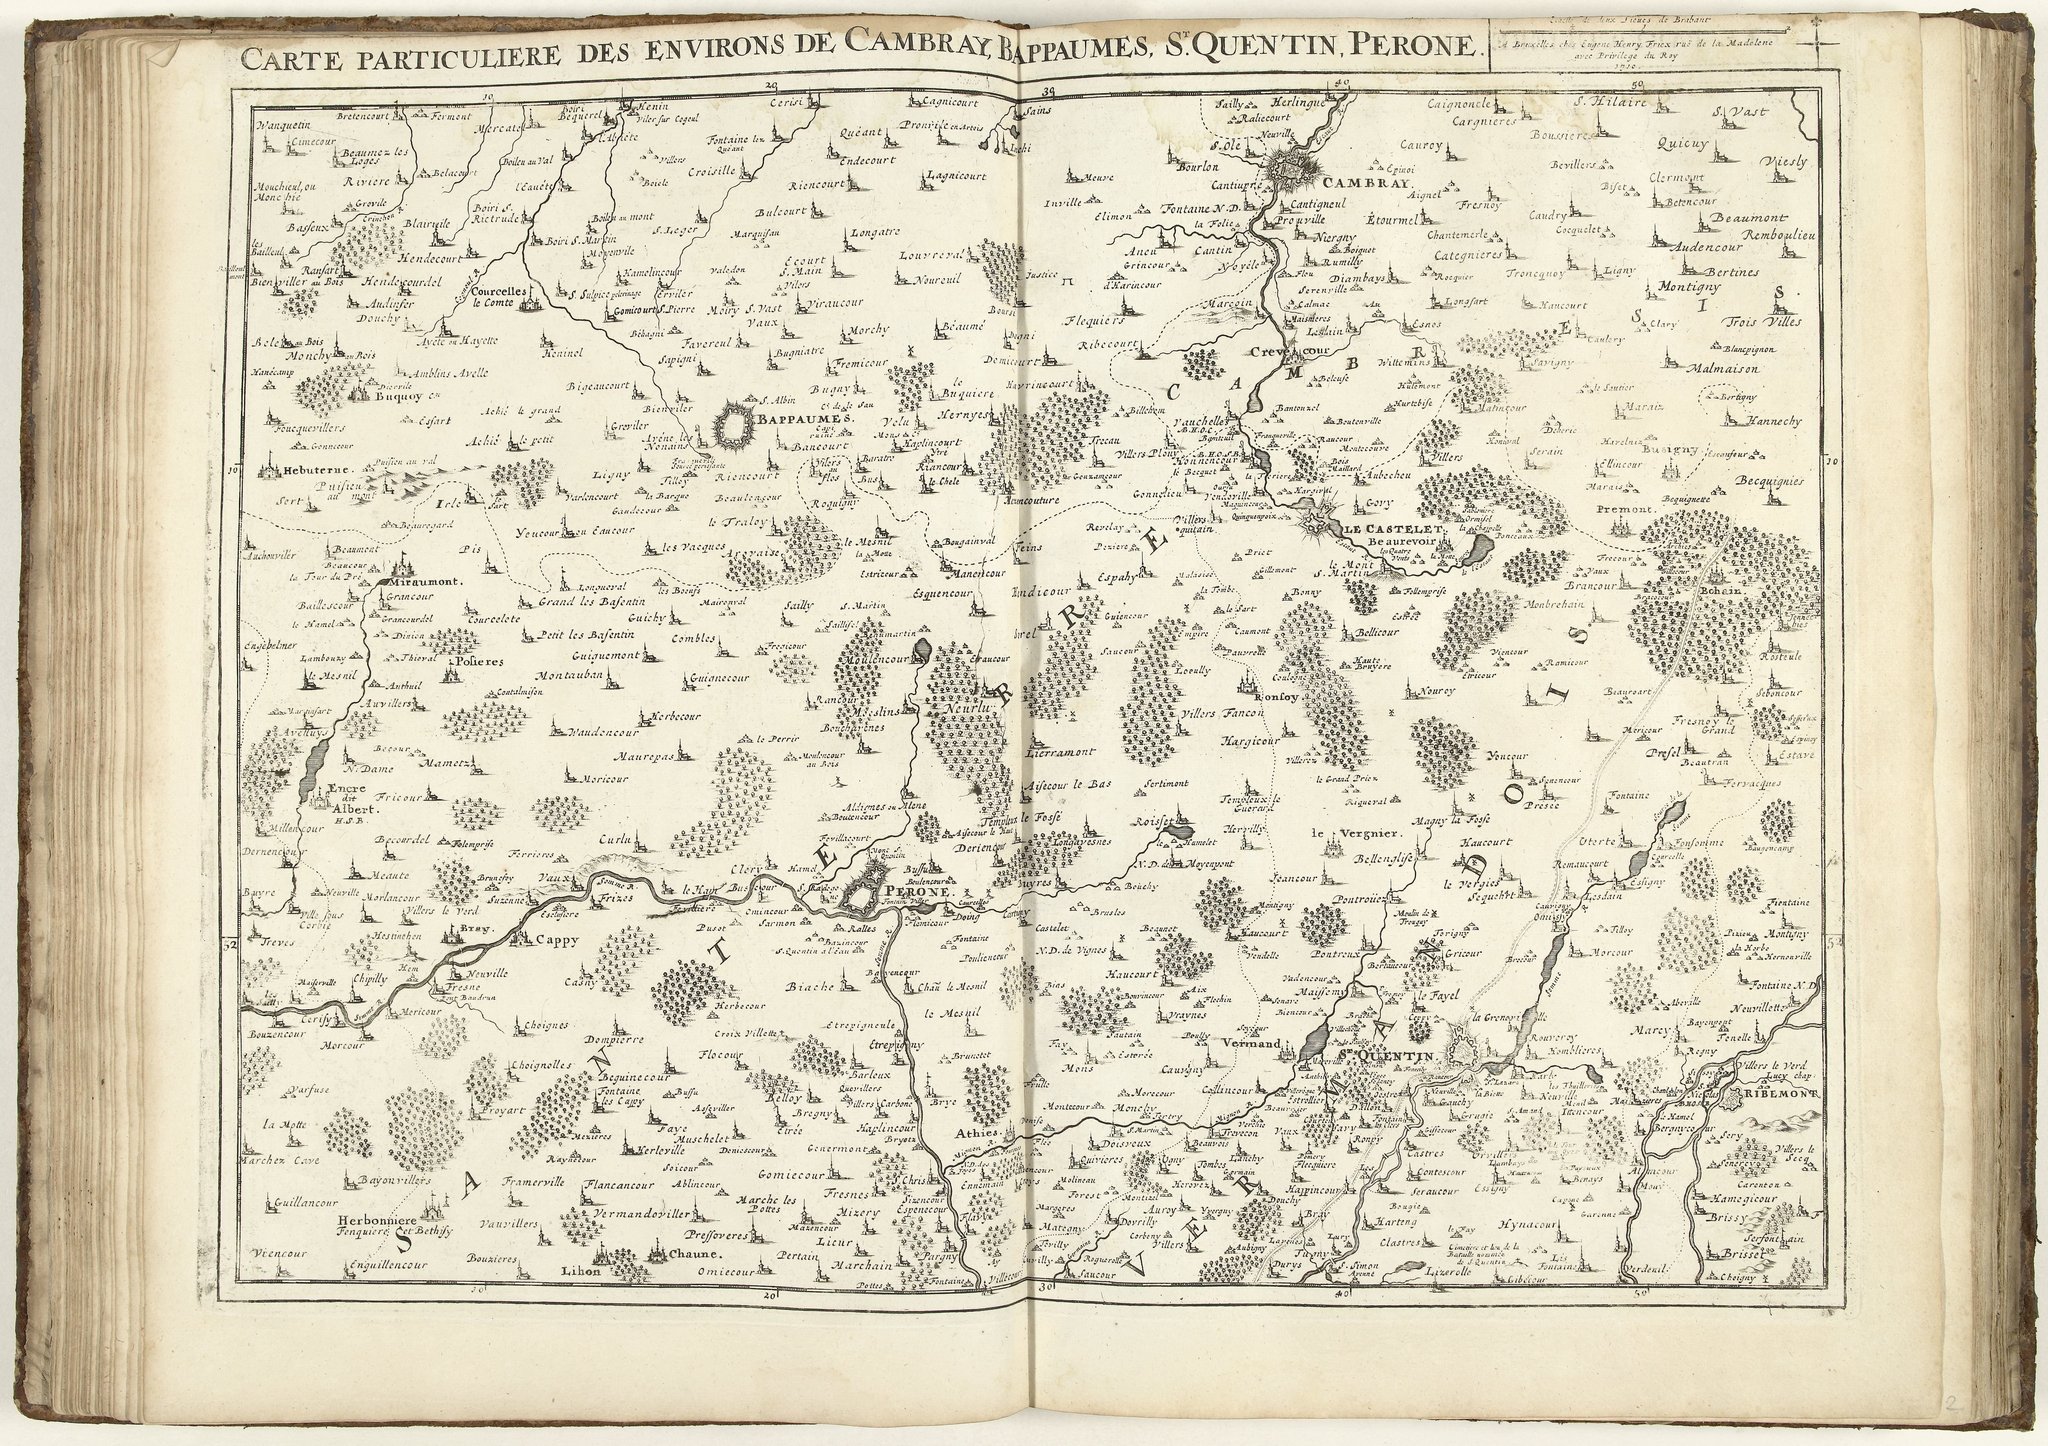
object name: print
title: Kaart van Noord-Frankrijk, 1710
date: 1710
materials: paper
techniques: engraving, etching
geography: brussels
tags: maps of separate countries or regions, northern france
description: Kaart van Noord-Frankrijk met de steden Cambrai, Péronne, St. Quentin en Bapaume, 1710. Onderdeel van een gebundelde verzameling van plannen van veldslagen en steden vermaard in de Spaanse Successieoorlog. Deze plaat behoort tot de eerste 24 platen die samen een zeer grote kaart van de Zuidelijke Nederlanden vormen.